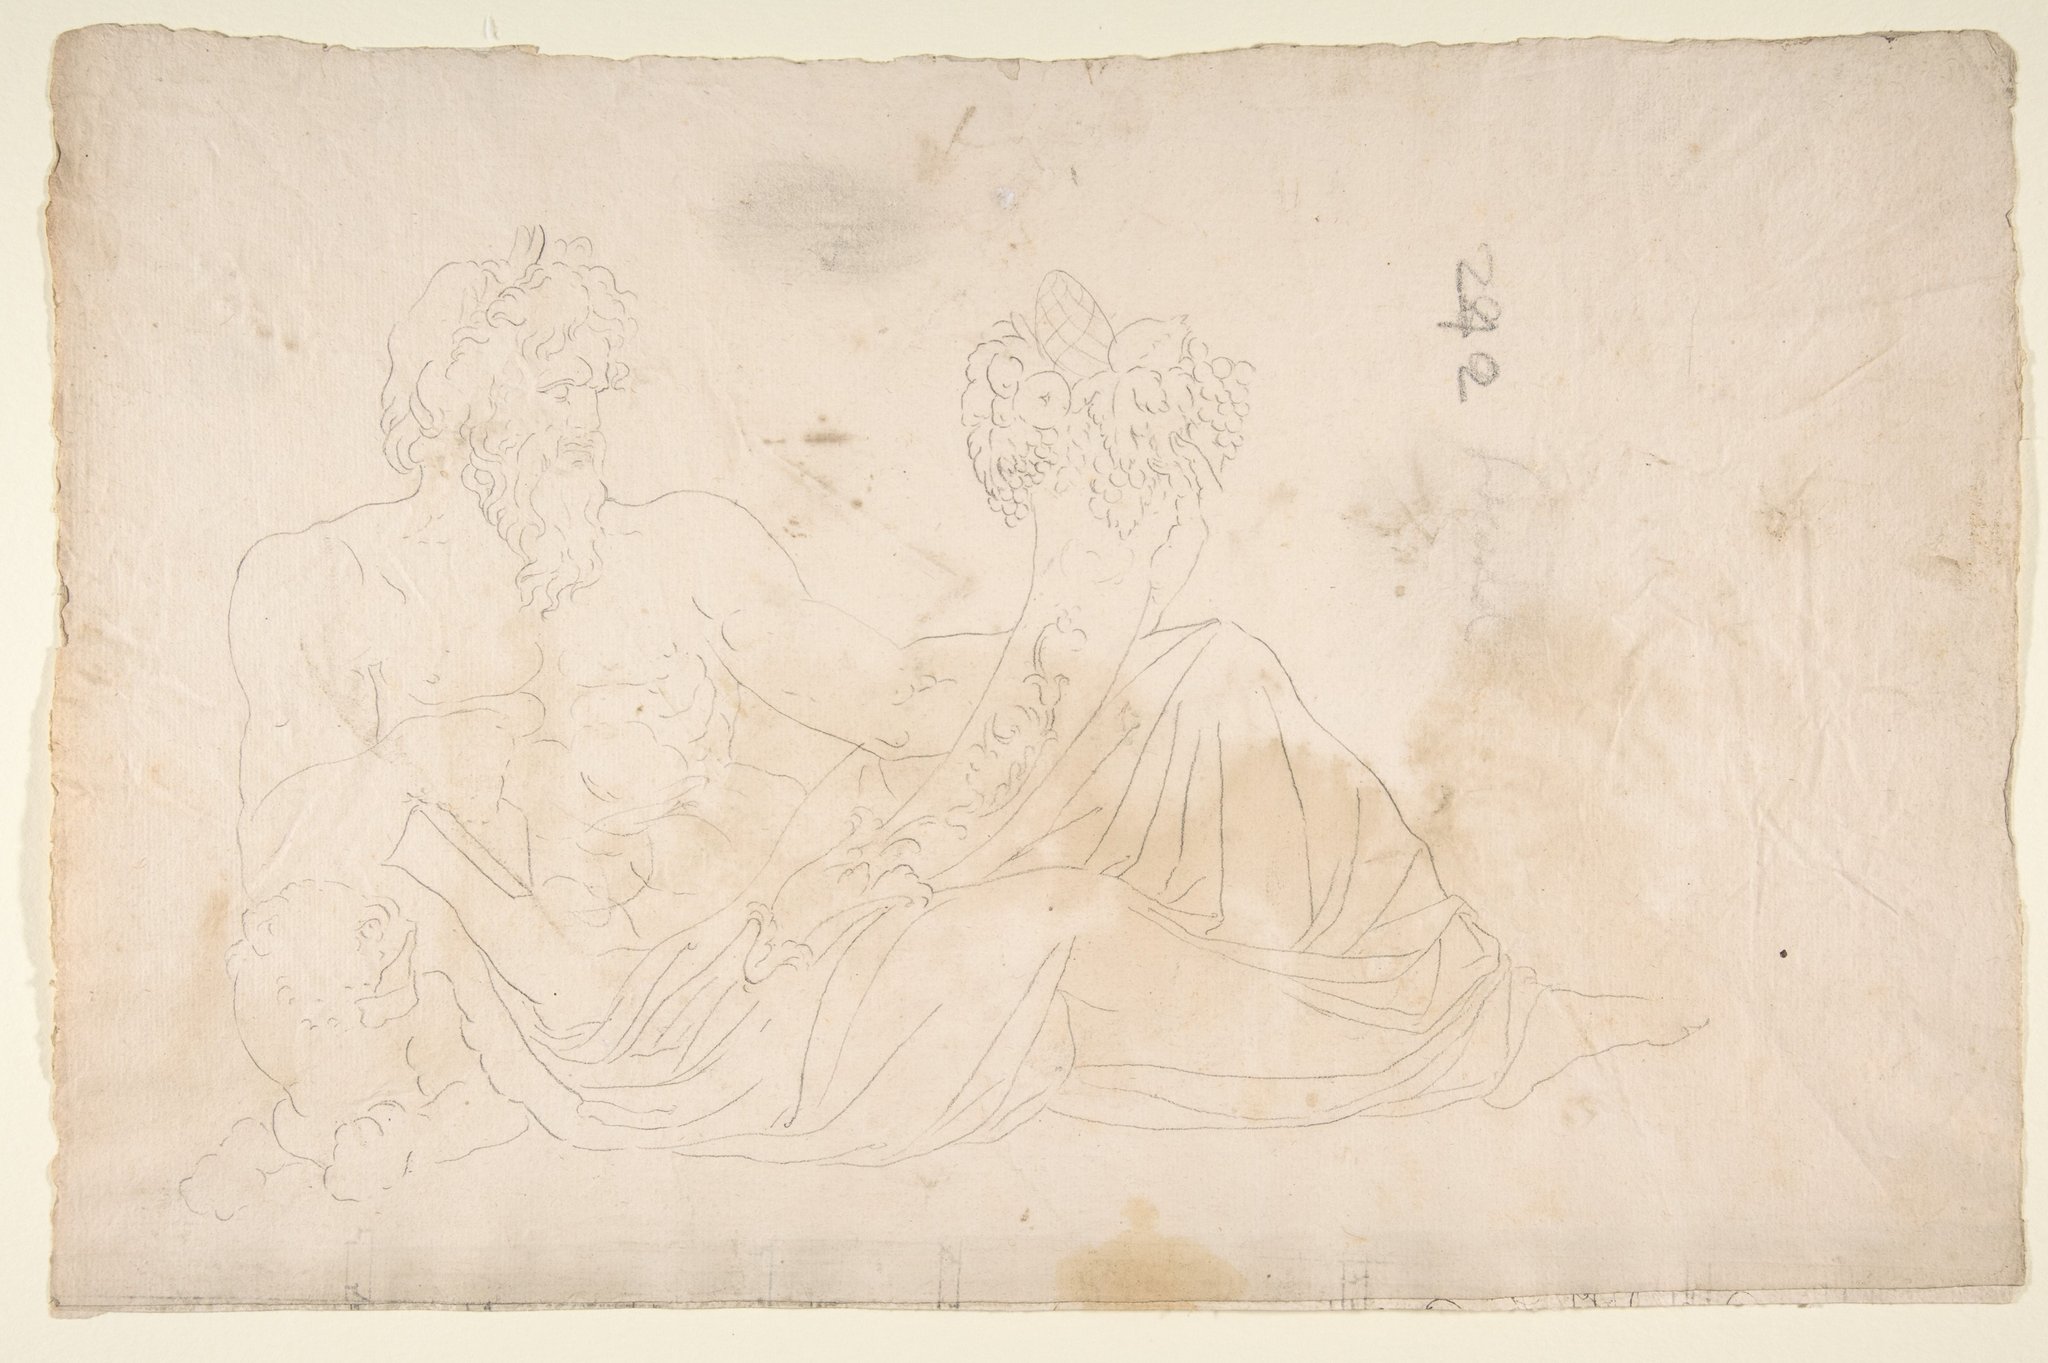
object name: drawing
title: River God (Tigris), sketch (recto) blank (verso)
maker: anonymous, french, 16th century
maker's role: draftsman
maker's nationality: french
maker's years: 1500-1600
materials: chalk, ink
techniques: incising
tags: men